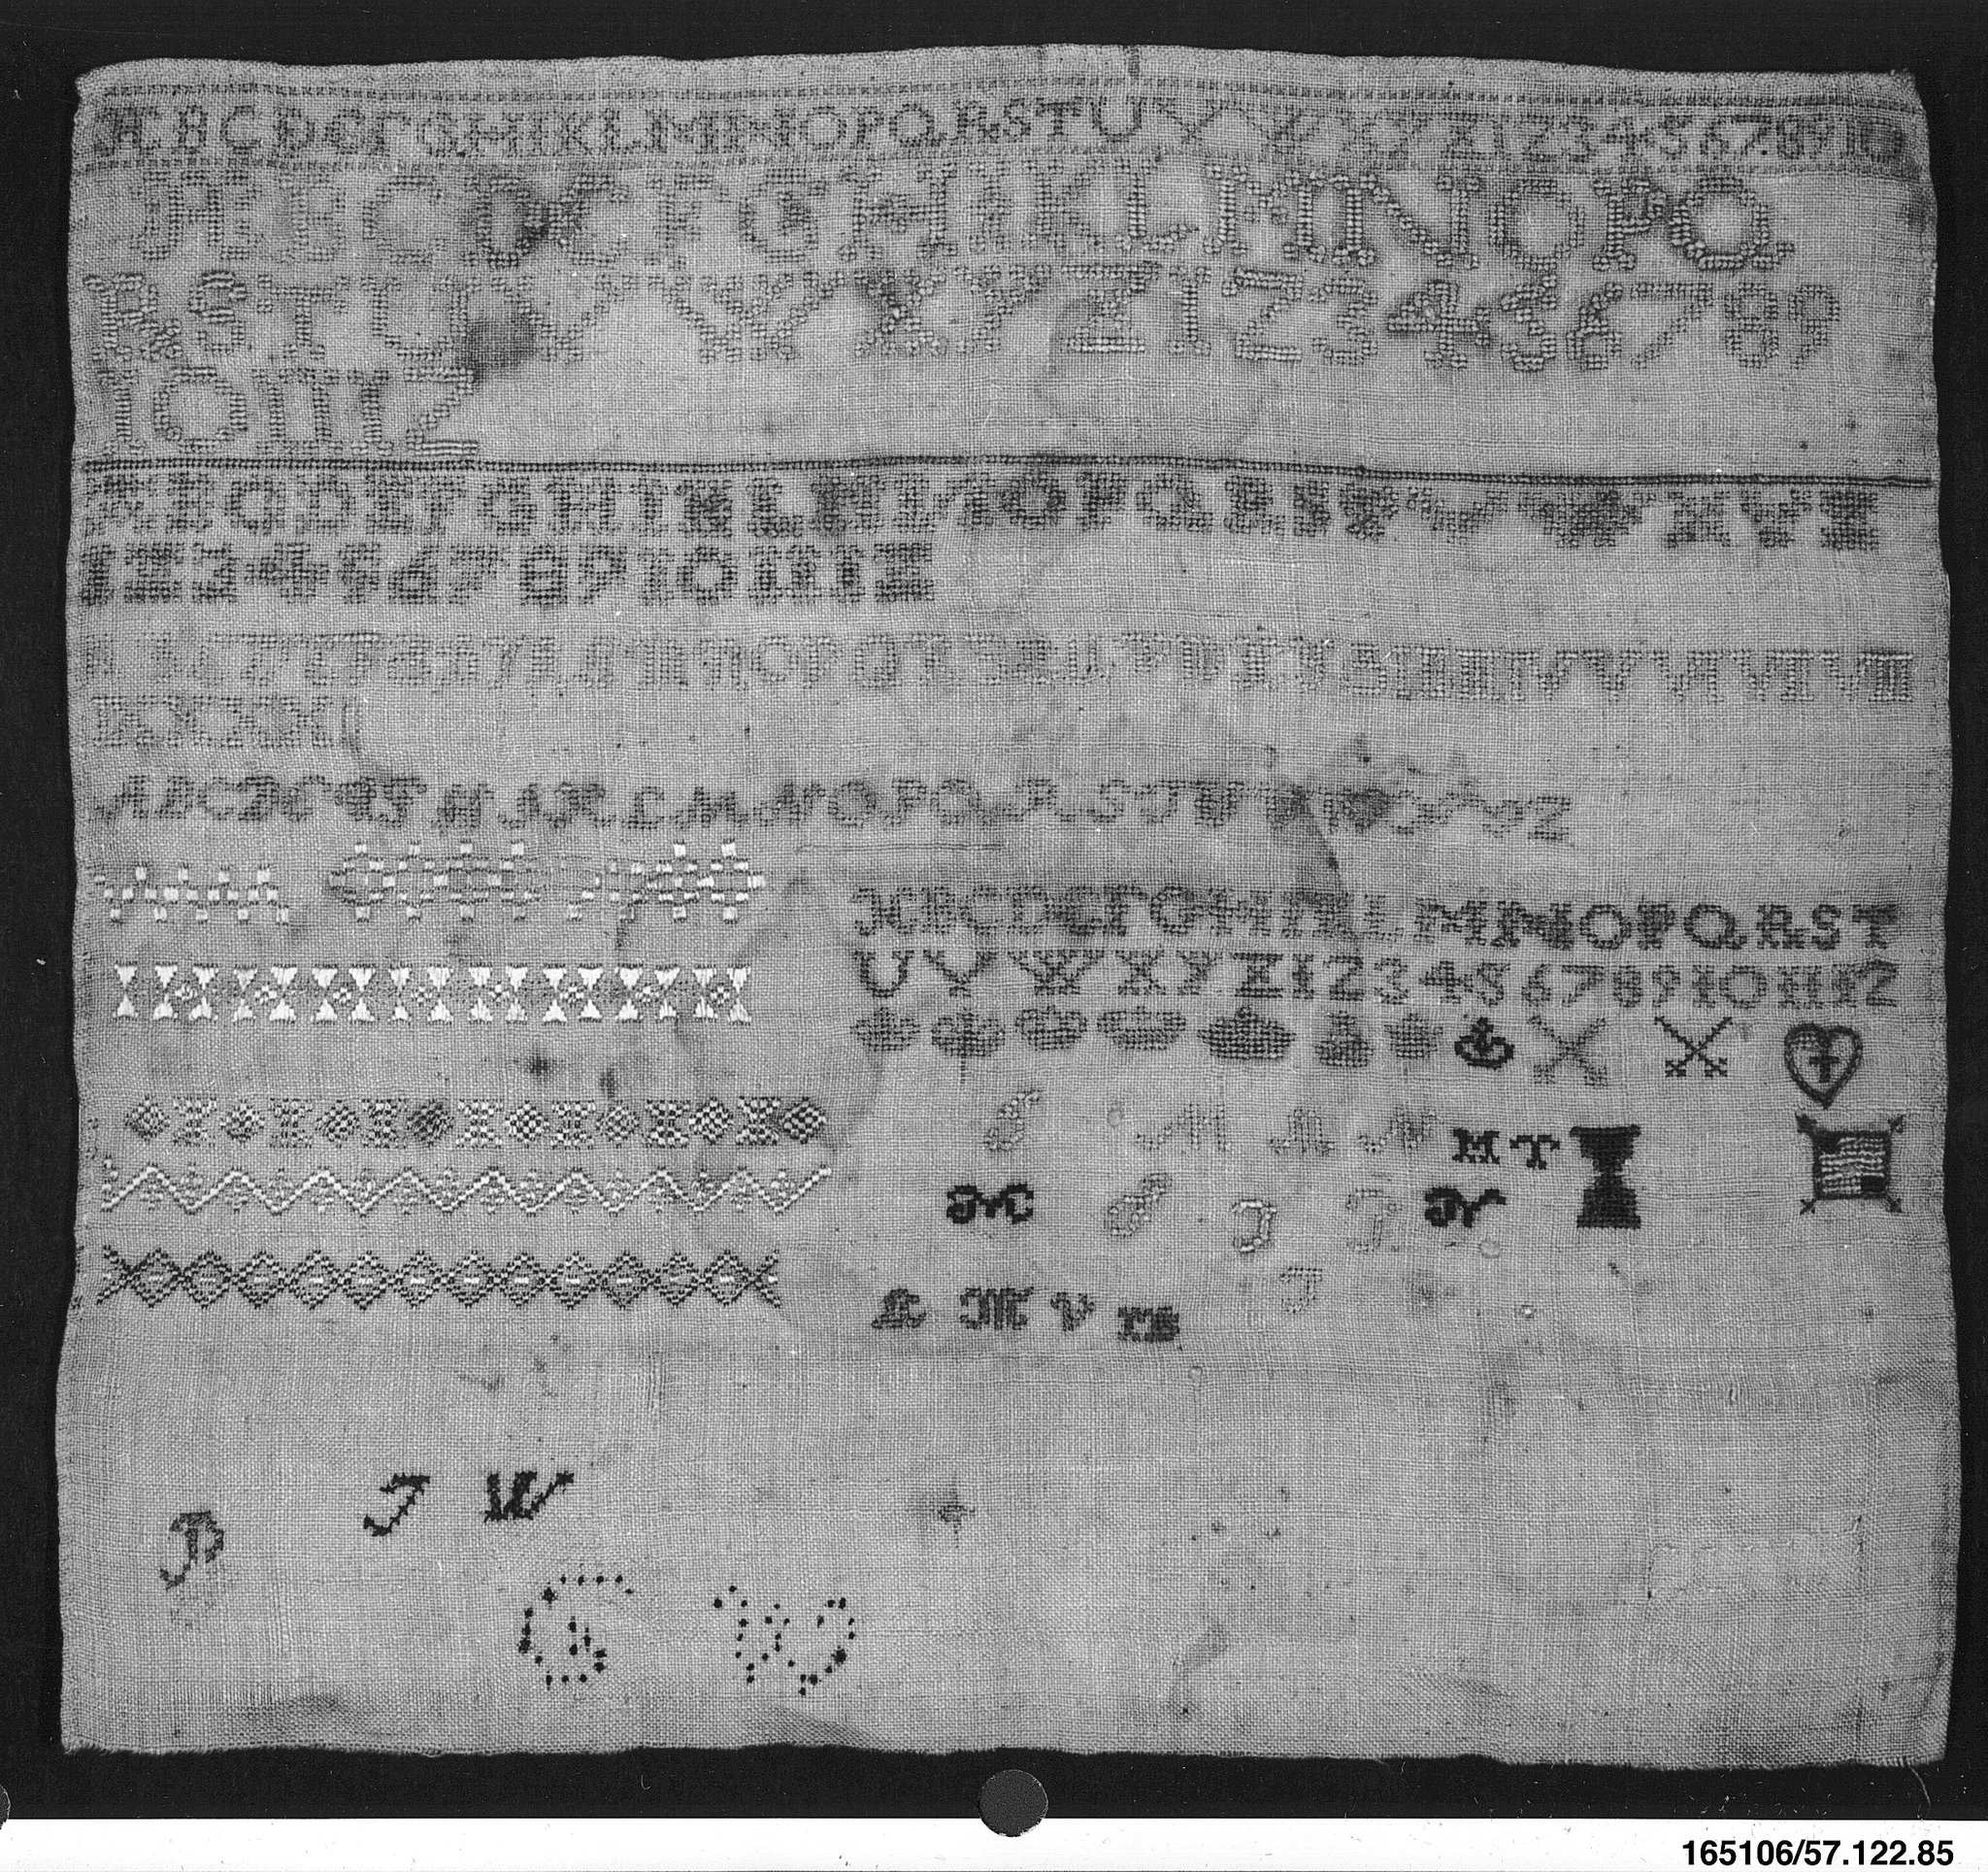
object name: sampler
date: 1701-1800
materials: linen, silk